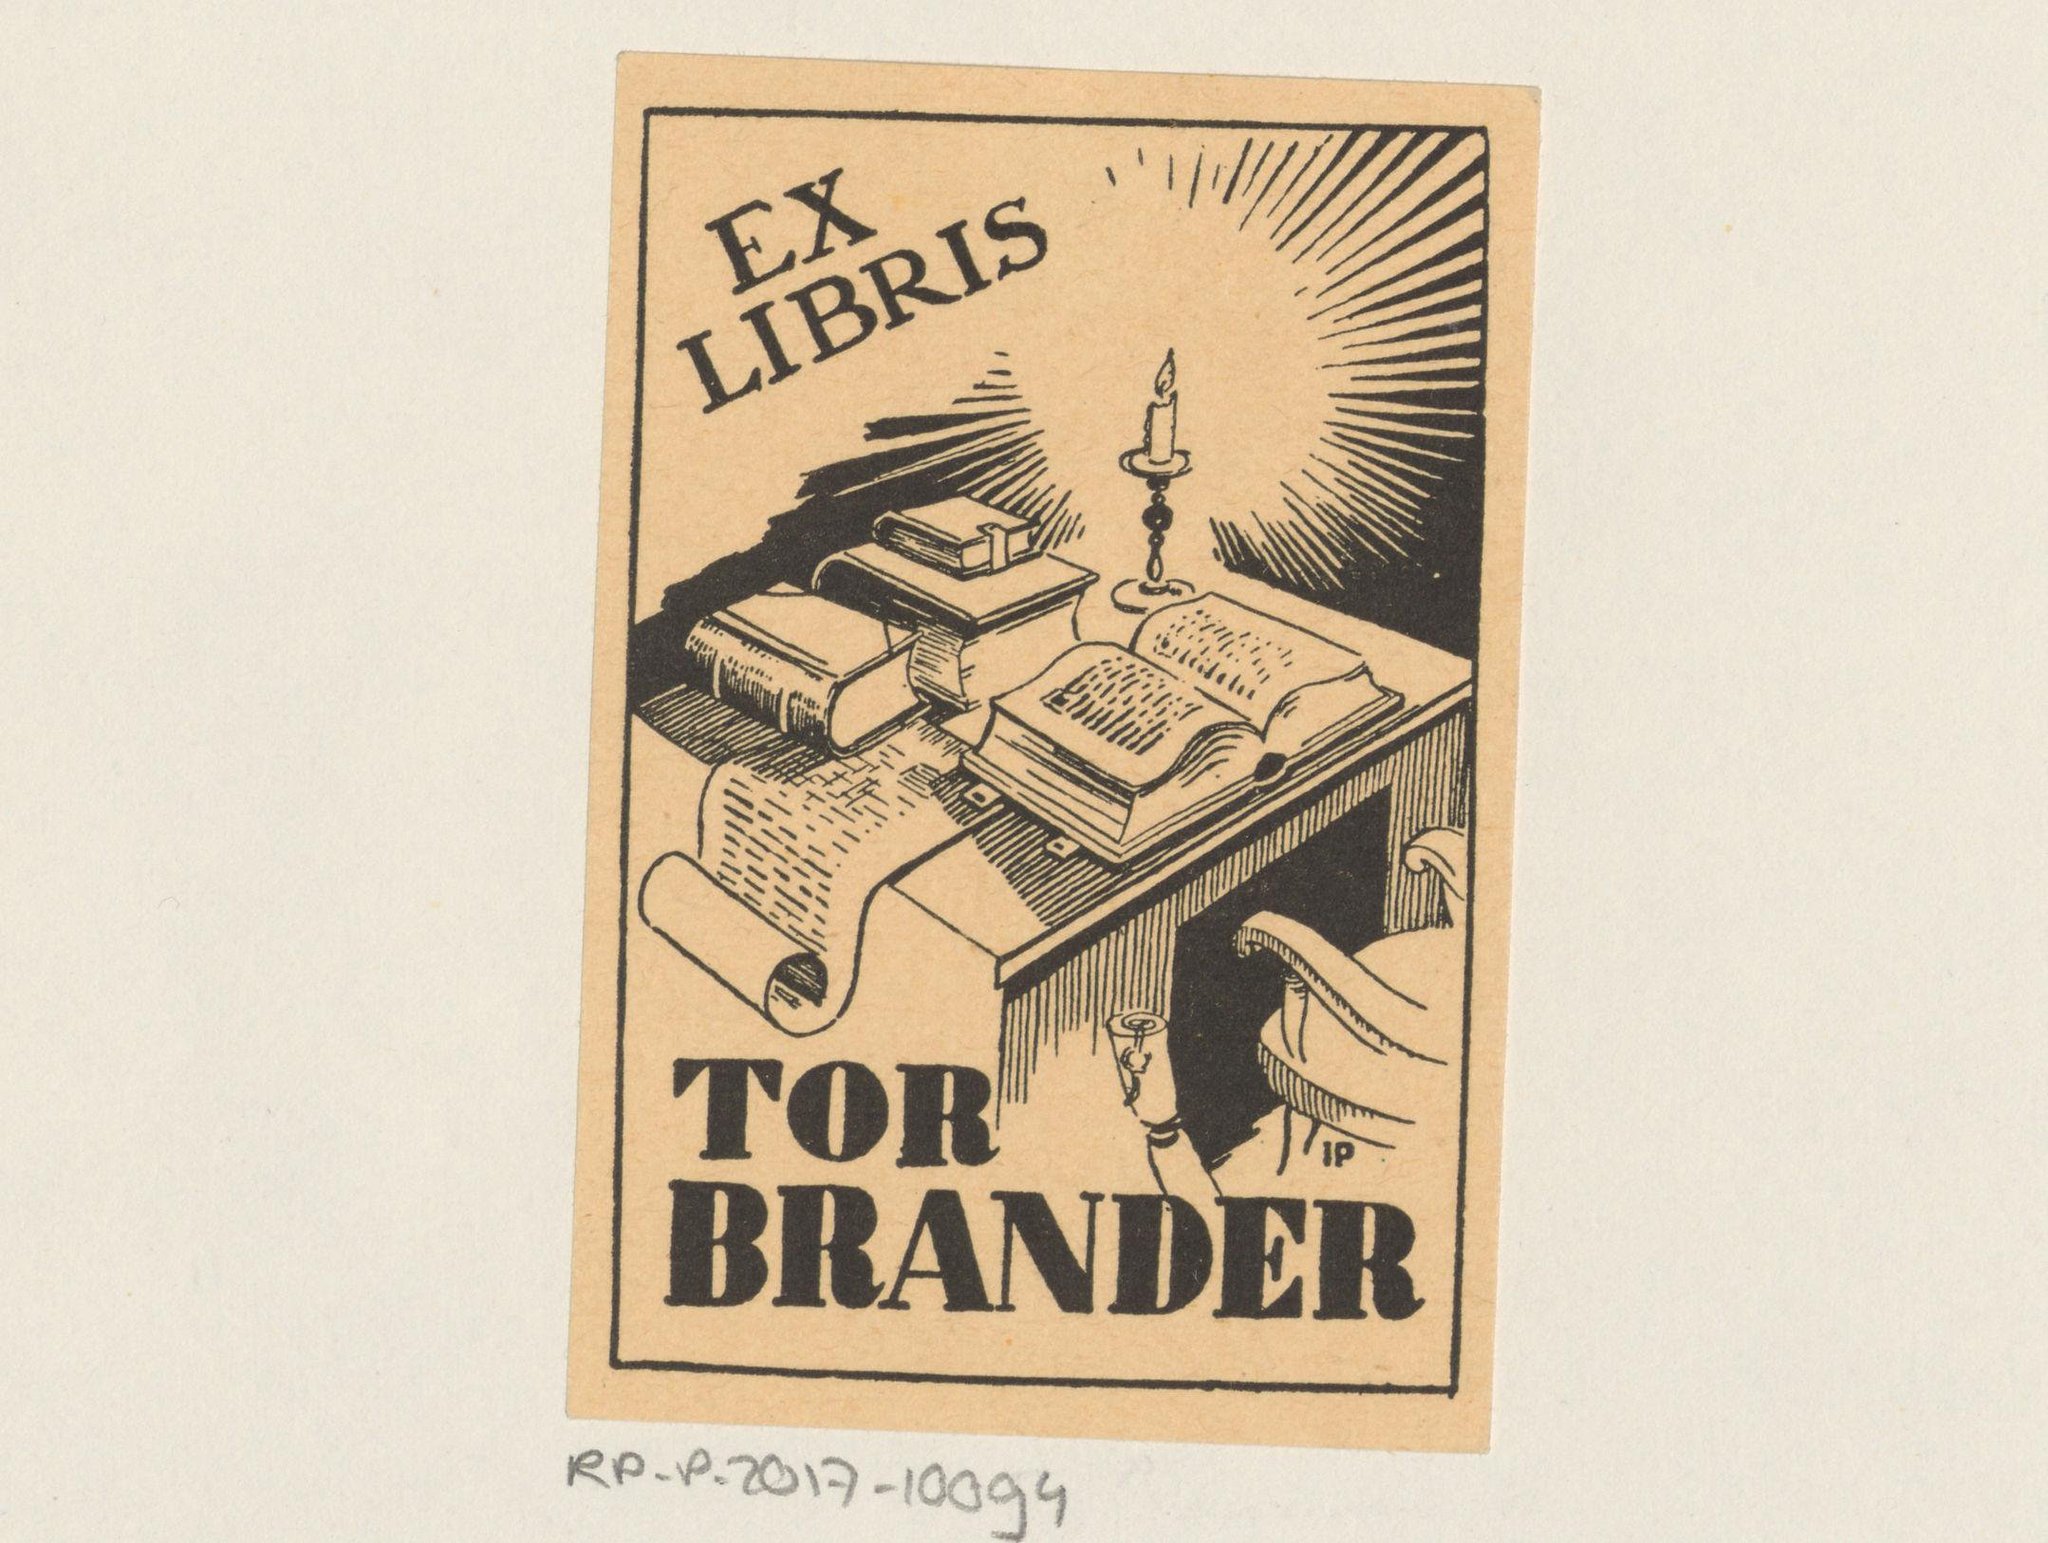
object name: bookplate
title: Ex libris van Tor Brander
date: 1945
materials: paper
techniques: printing block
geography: finland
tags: book, candle